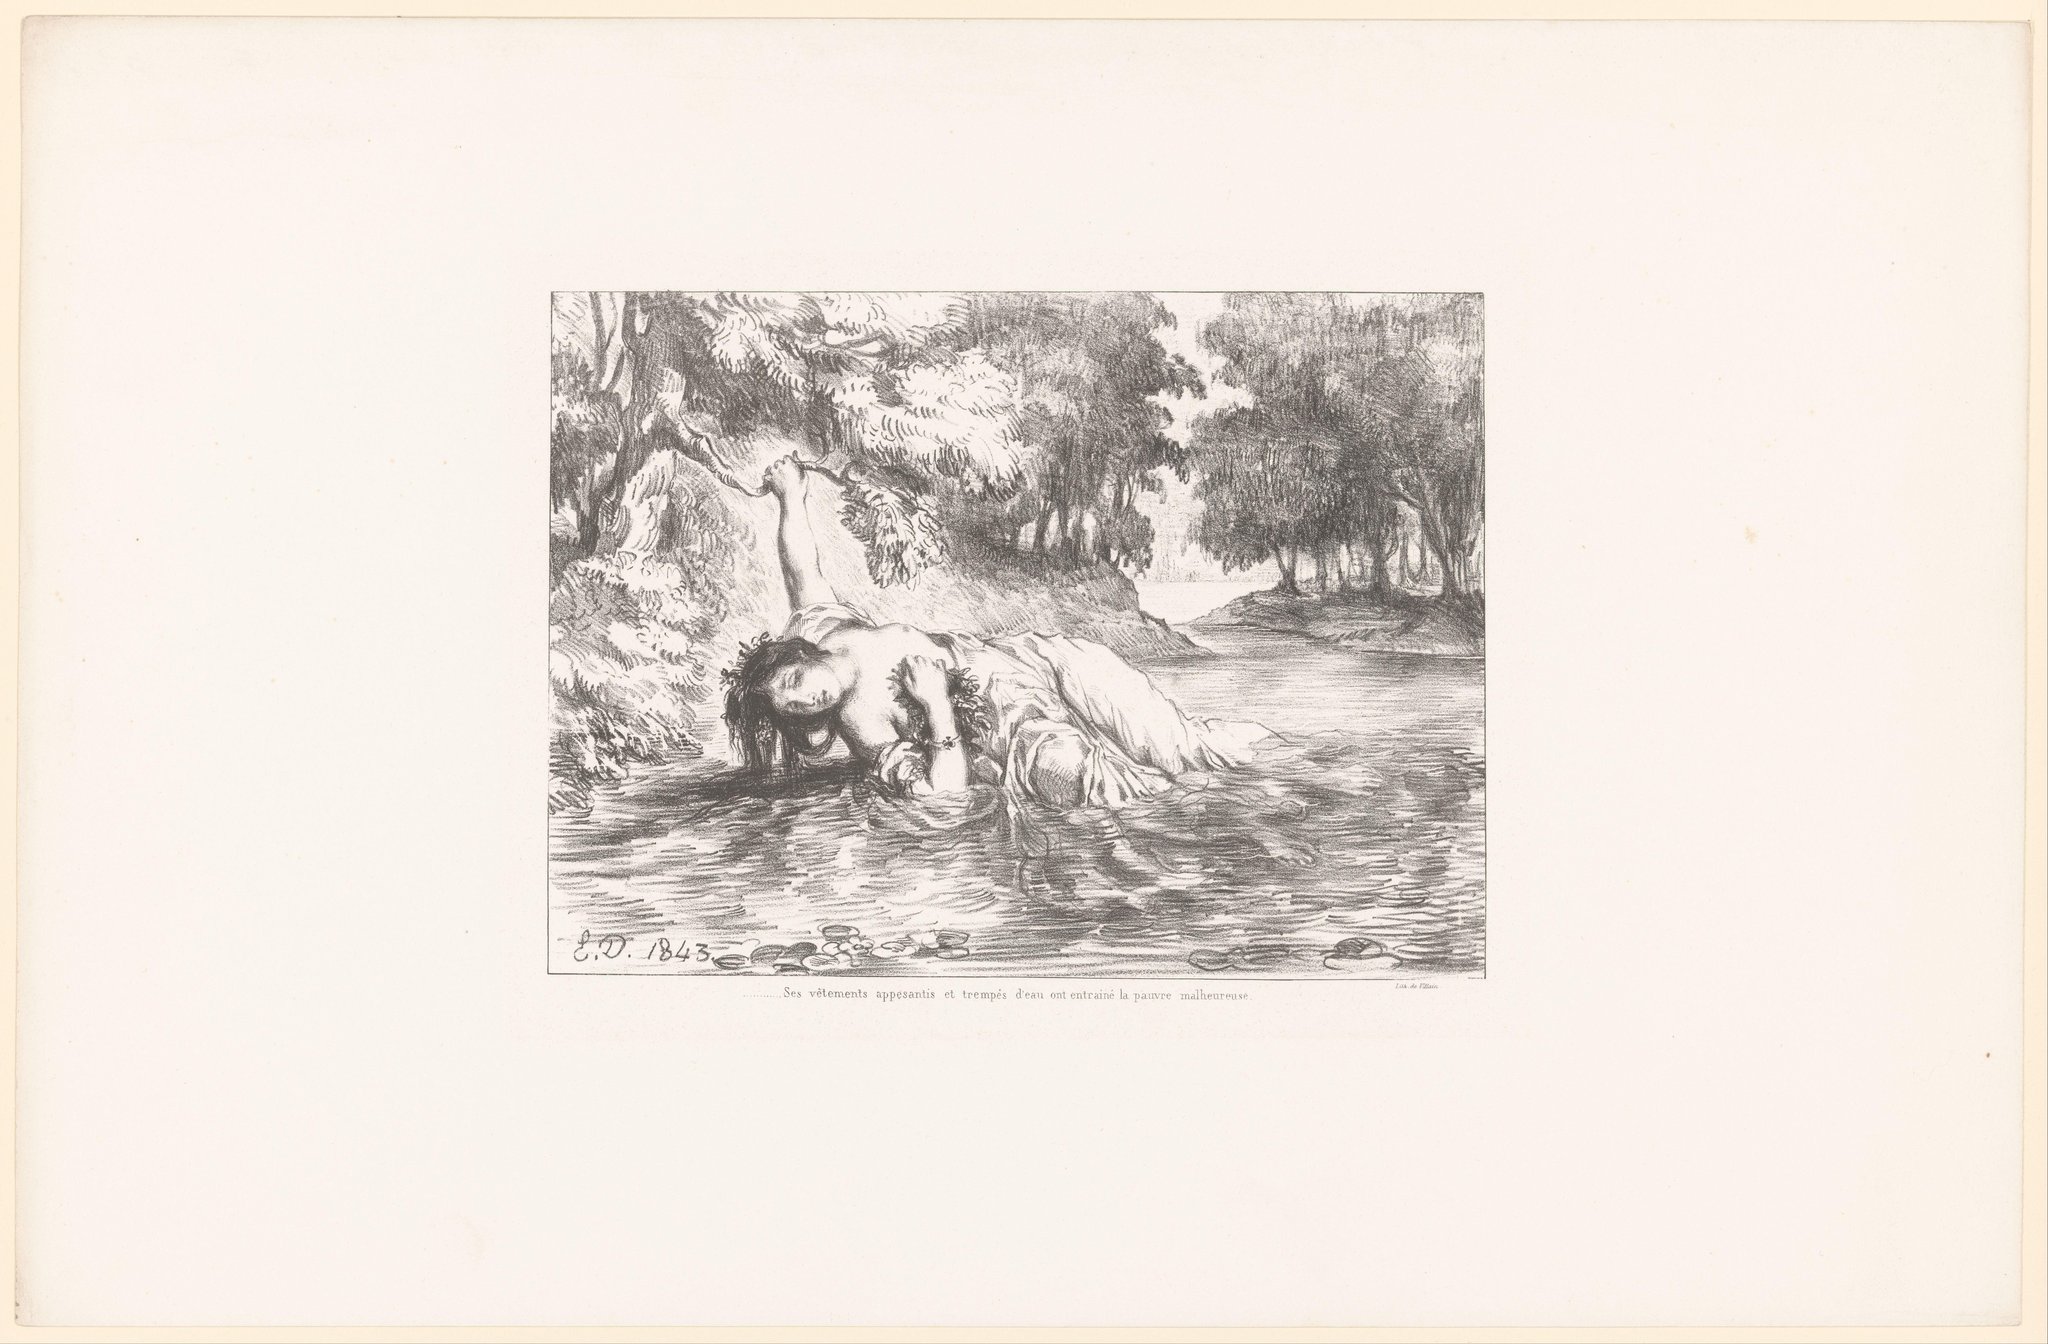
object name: print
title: Ses vêtements appesantis et trempés d'eau ont entrainé la pauvre malheureuse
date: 1843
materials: paper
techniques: lithograph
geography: paris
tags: hamlet, prince of denmark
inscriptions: collector's mark: Lugt 2760, collector's mark: Lugt 2228a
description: Prent maakt deel uit van een omslag met veertien prenten.